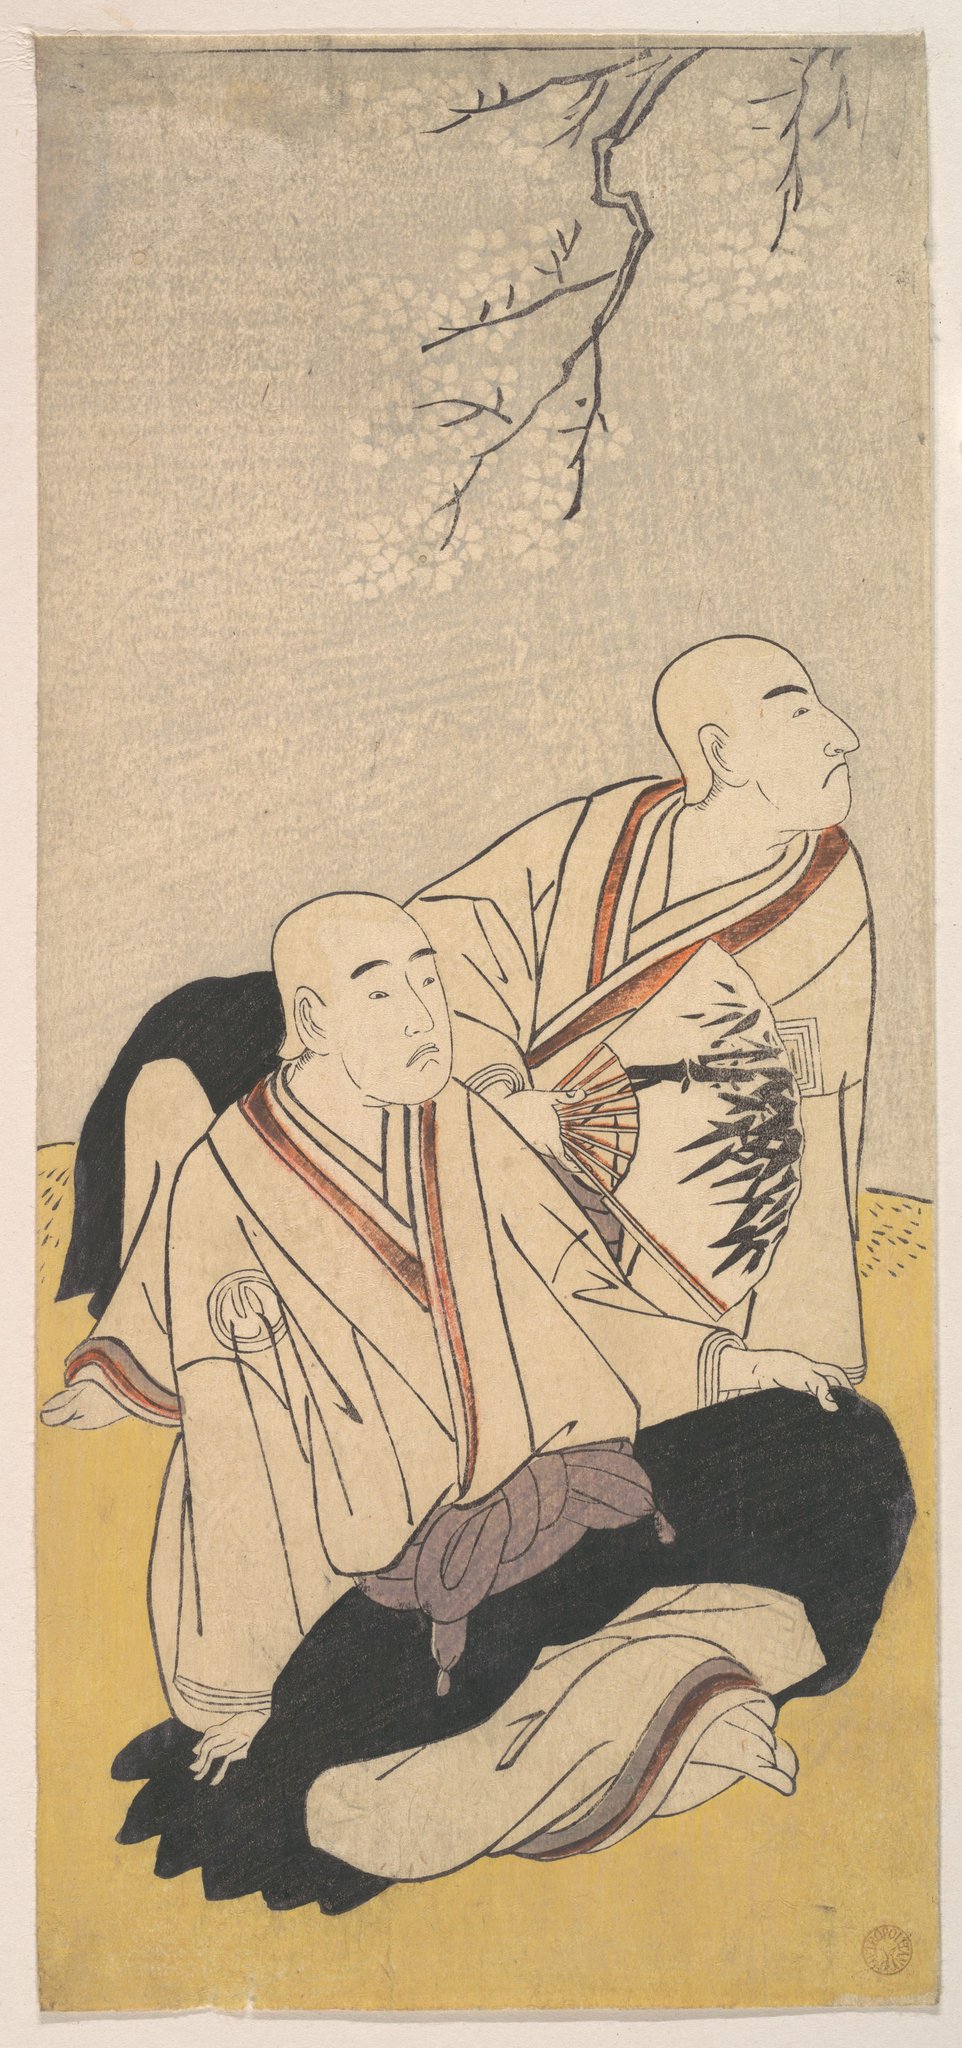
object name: woodblock print nishiki e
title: The Third Sawamura Sojuro & the Second Ichikawa Monnosuke as Buddhist Monks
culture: japanese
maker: katsukawa shunshō 勝川春章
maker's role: artist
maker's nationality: japanese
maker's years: 1726-1792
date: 1791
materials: ink, paper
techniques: nishiki e, woodblock print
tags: fans,men,monks,actors